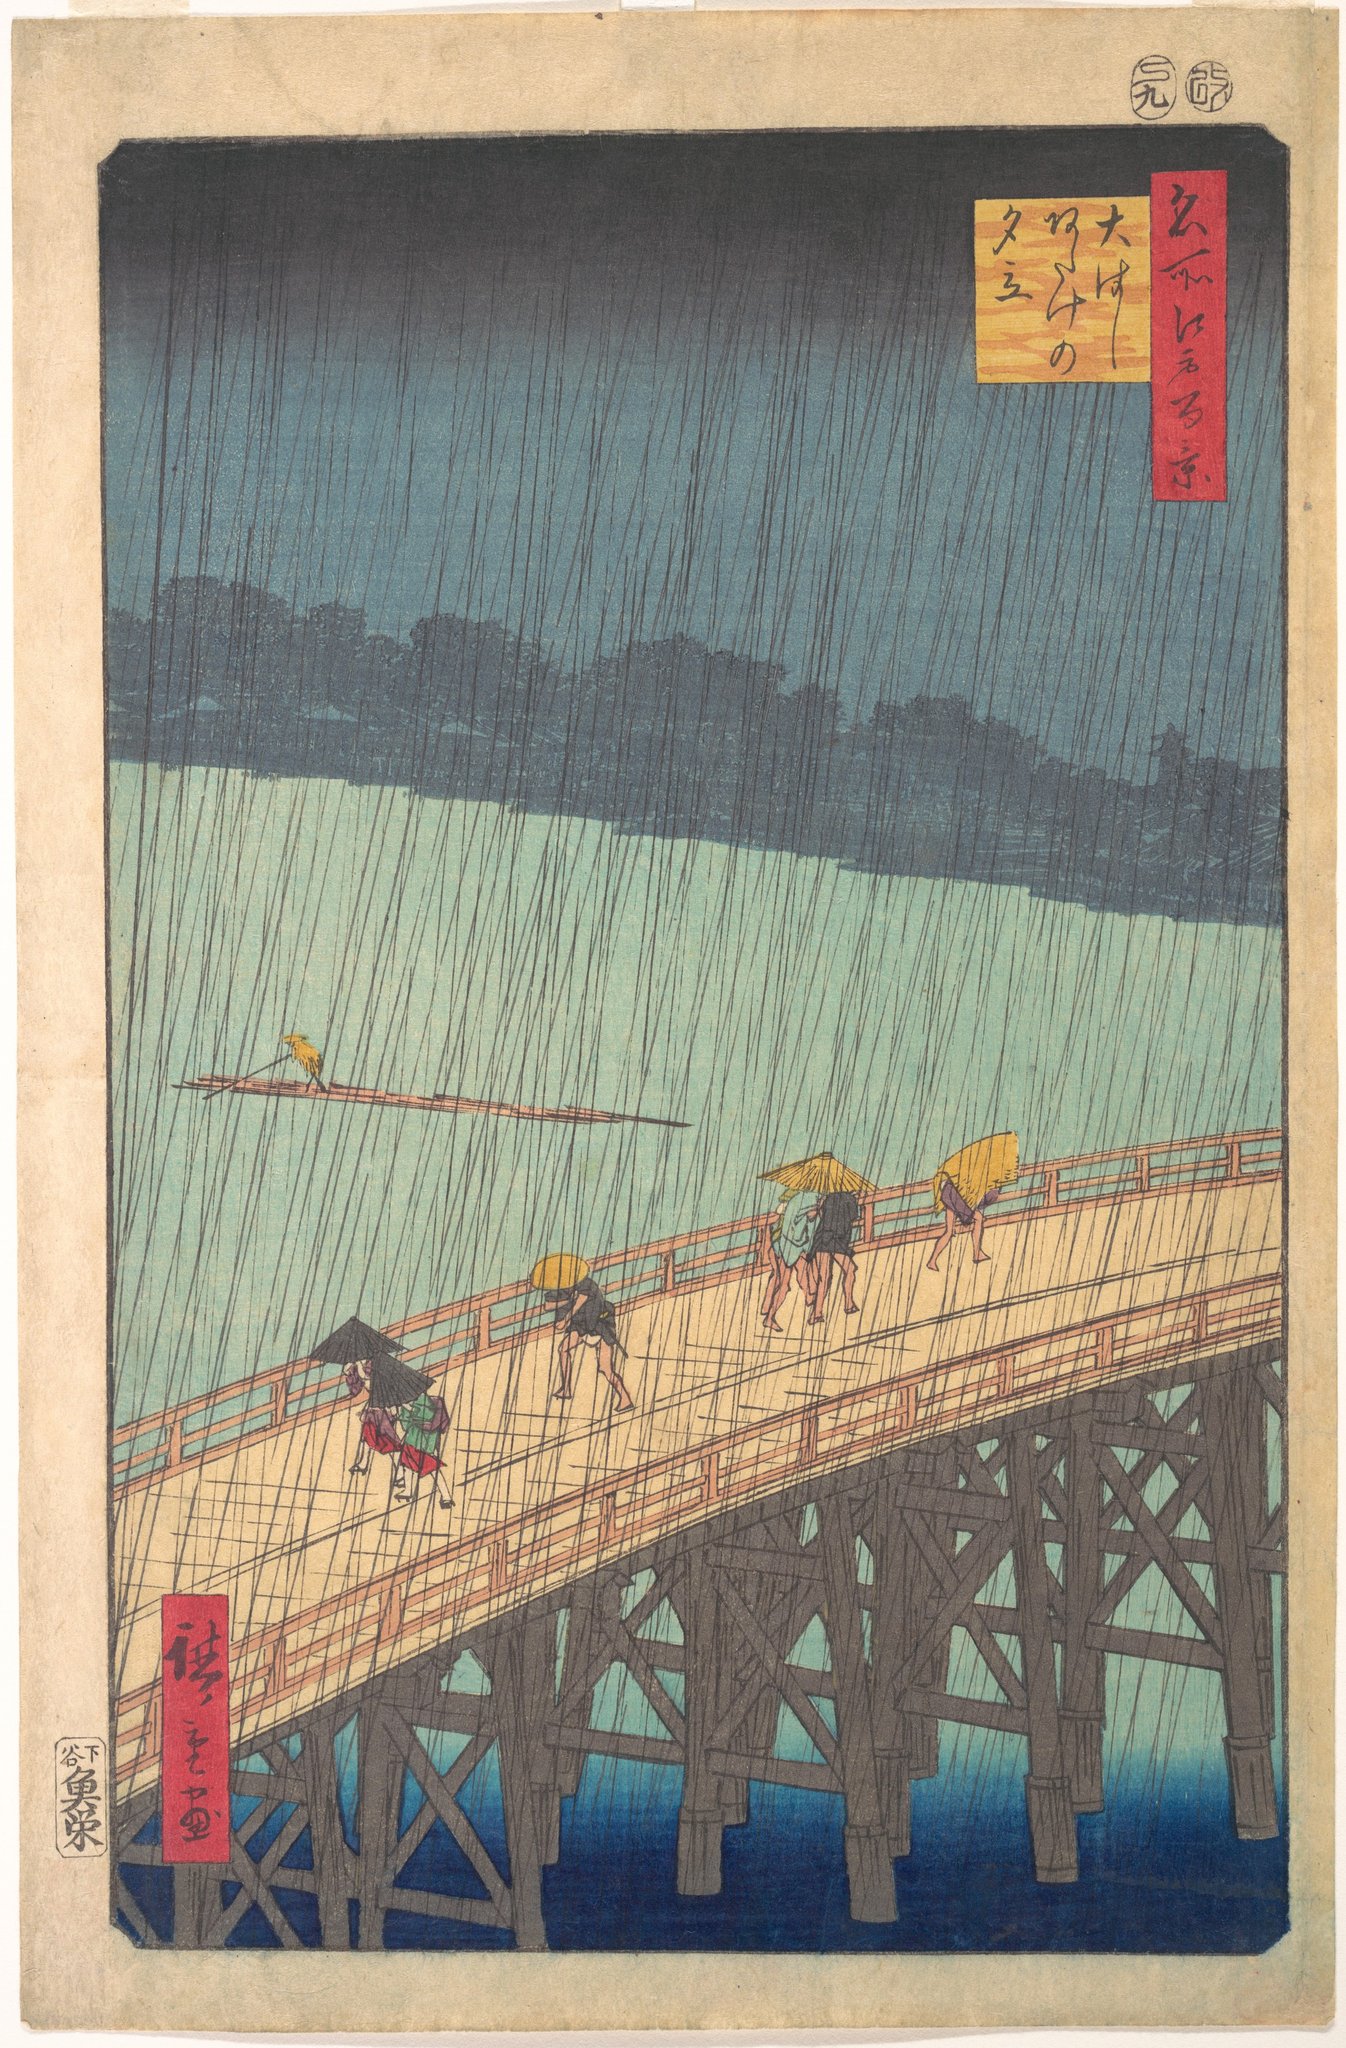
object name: print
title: Sudden Shower over Shin-Ōhashi Bridge and Atake (Ōhashi Atake no yūdachi), from the series One Hundred Famous Views of Edo (Meisho Edo hyakkei)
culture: japanese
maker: utagawa hiroshige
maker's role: artist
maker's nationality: japanese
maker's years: 1797-1858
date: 1857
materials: ink, paper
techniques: woodblock print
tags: human figures,bridges,rivers,rain,boats